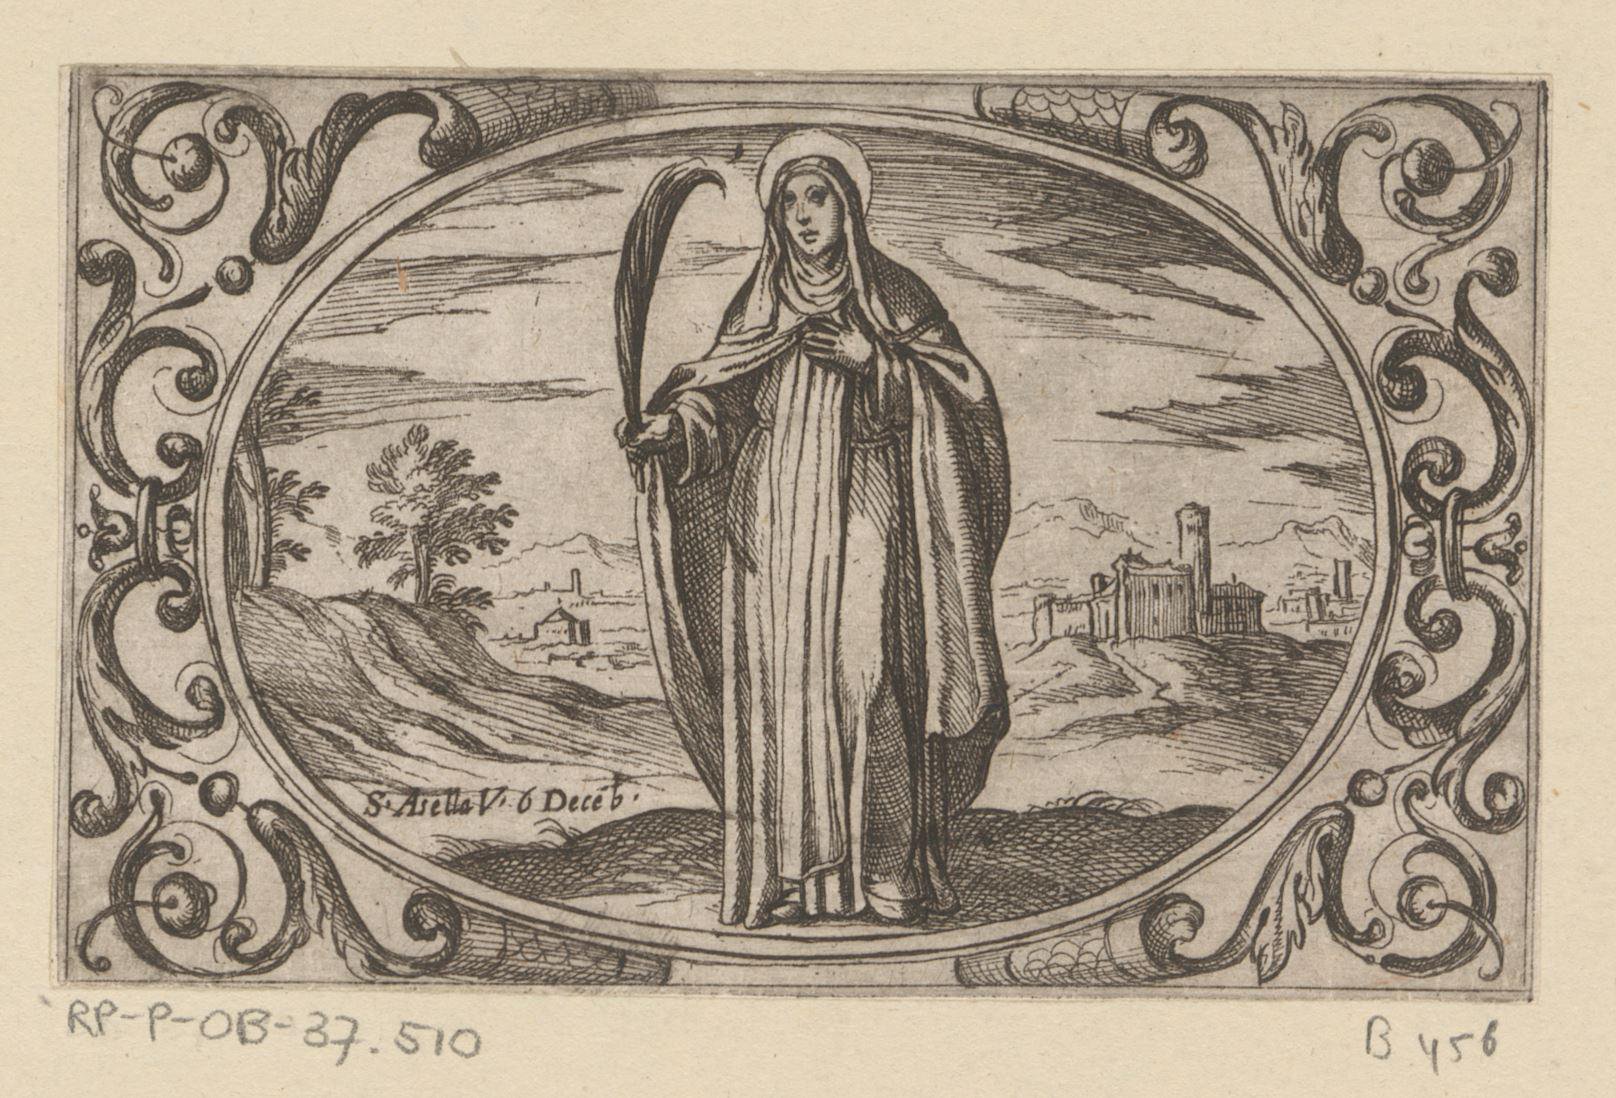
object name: print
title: Romeinse martelaressen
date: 1565-1630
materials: paper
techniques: etching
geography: vatican city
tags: martyr(s) (often with palm-branches) - qq - female martyr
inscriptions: collector's mark: Lugt 240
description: Deze prent maakt deel uit van een reeks van 73 prenten (+ titelprent) met voorstellingen van Romeinse martelaressen.